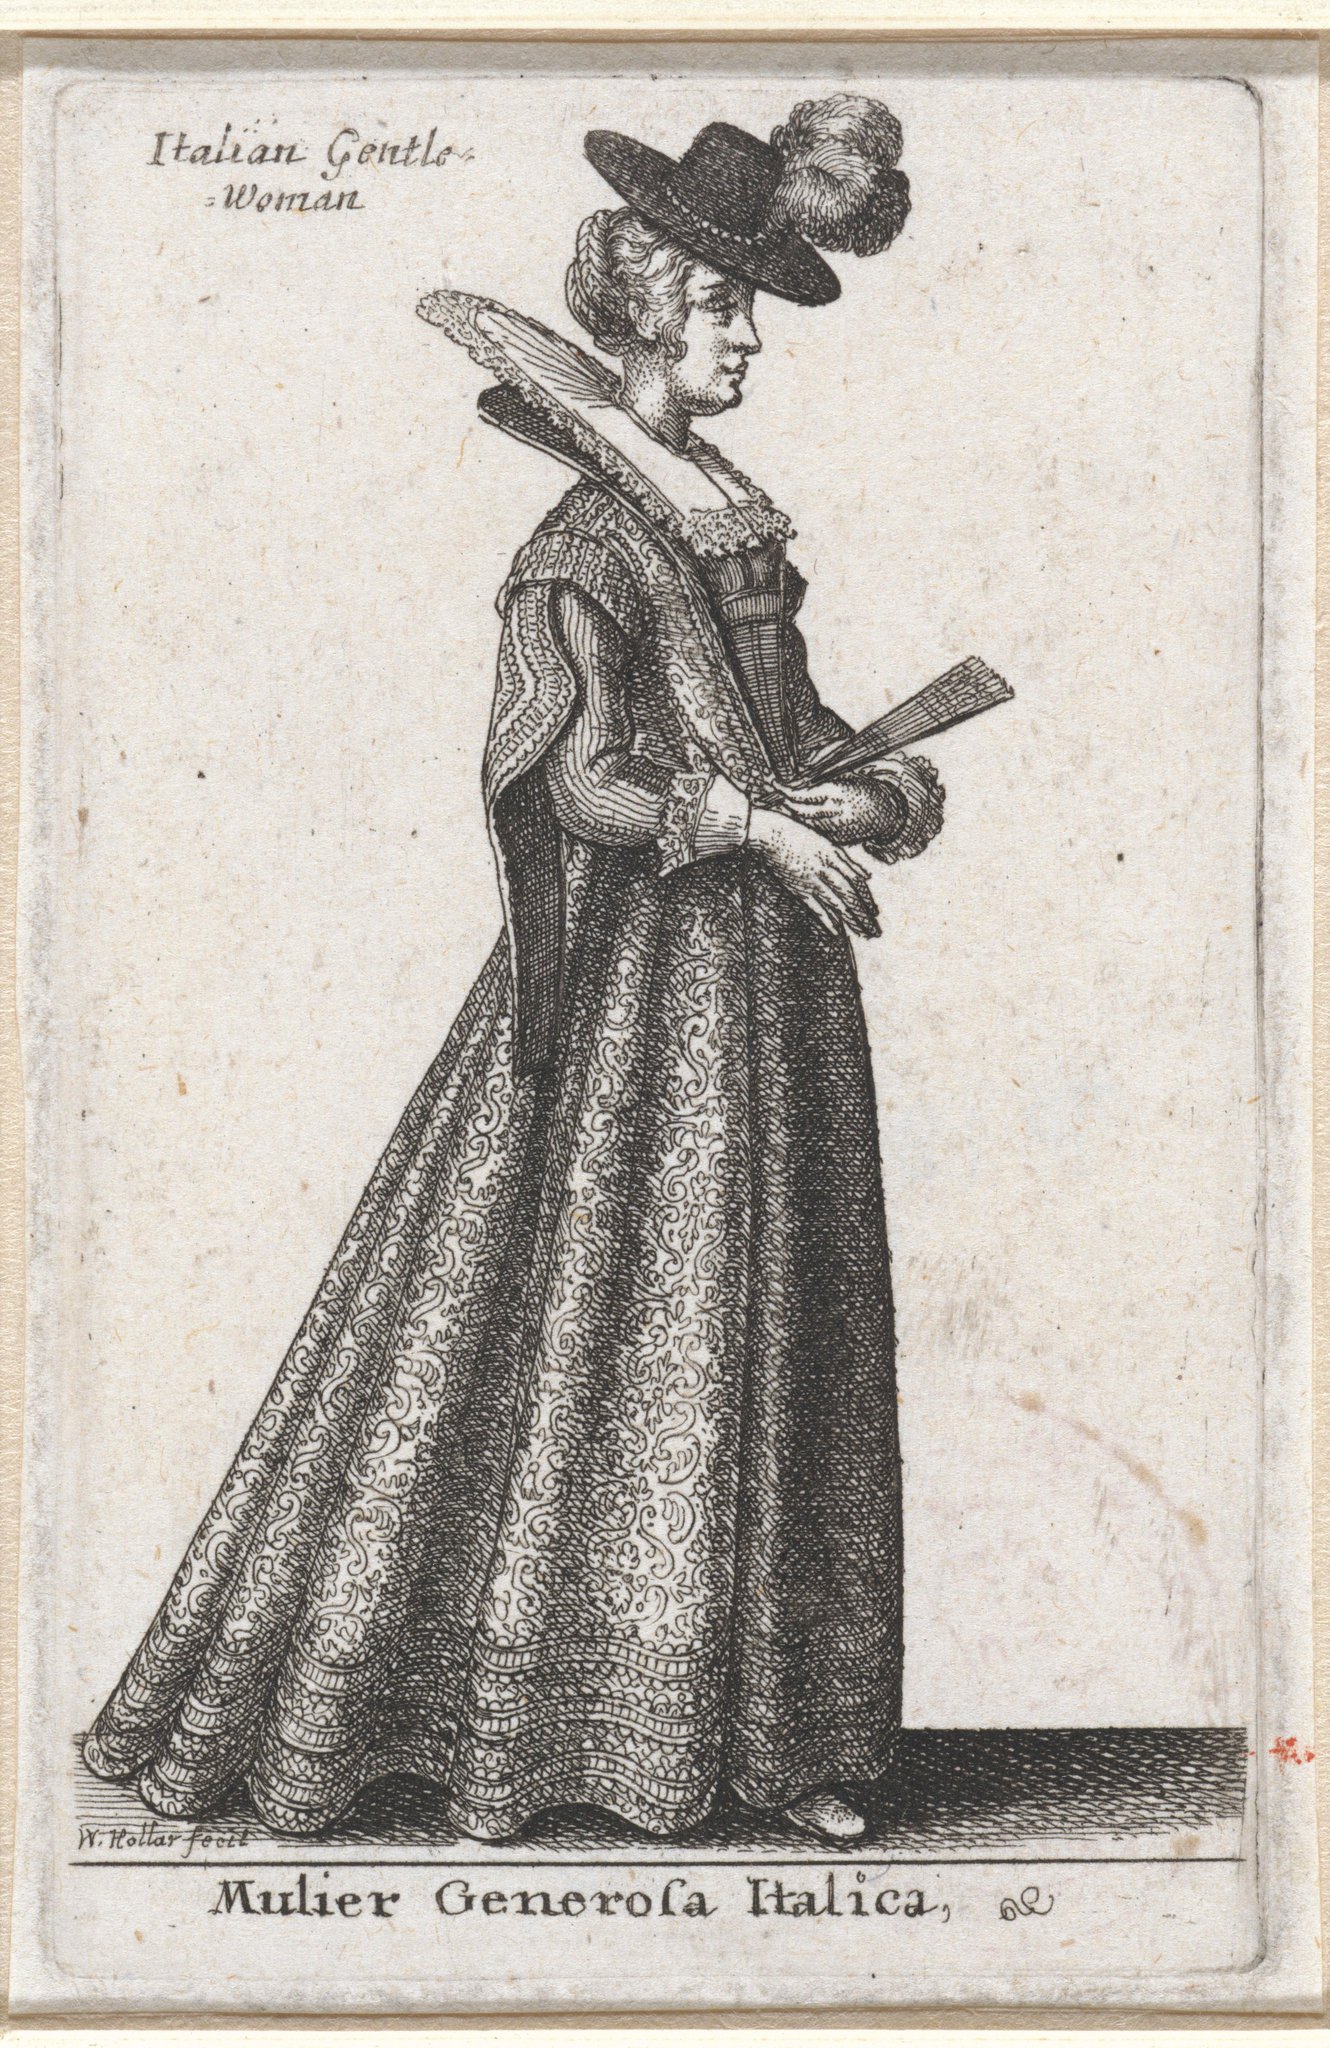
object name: costume print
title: Mulier Generosa Italica / Italian Gentle Woman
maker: wenceslaus hollar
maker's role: draughtsman, print maker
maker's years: 1607-1677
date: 1644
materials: paper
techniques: etching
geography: london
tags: italy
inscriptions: collector's mark: Lugt 240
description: Vrouw van aanzien uit Italië, in profiel naar rechts, een waaier in de hand. Schuin op het voorhoofd een kleine zwarte hoed met veer. Grote platte kraag, afgezet met kant boven een overkleed (vlieger ?) van brokaat, met losse siermouwen. Een dichtgevouwen waaier in de linkerhand. No. 6 uit serie met twaalf kostuums uit verschillende landen.